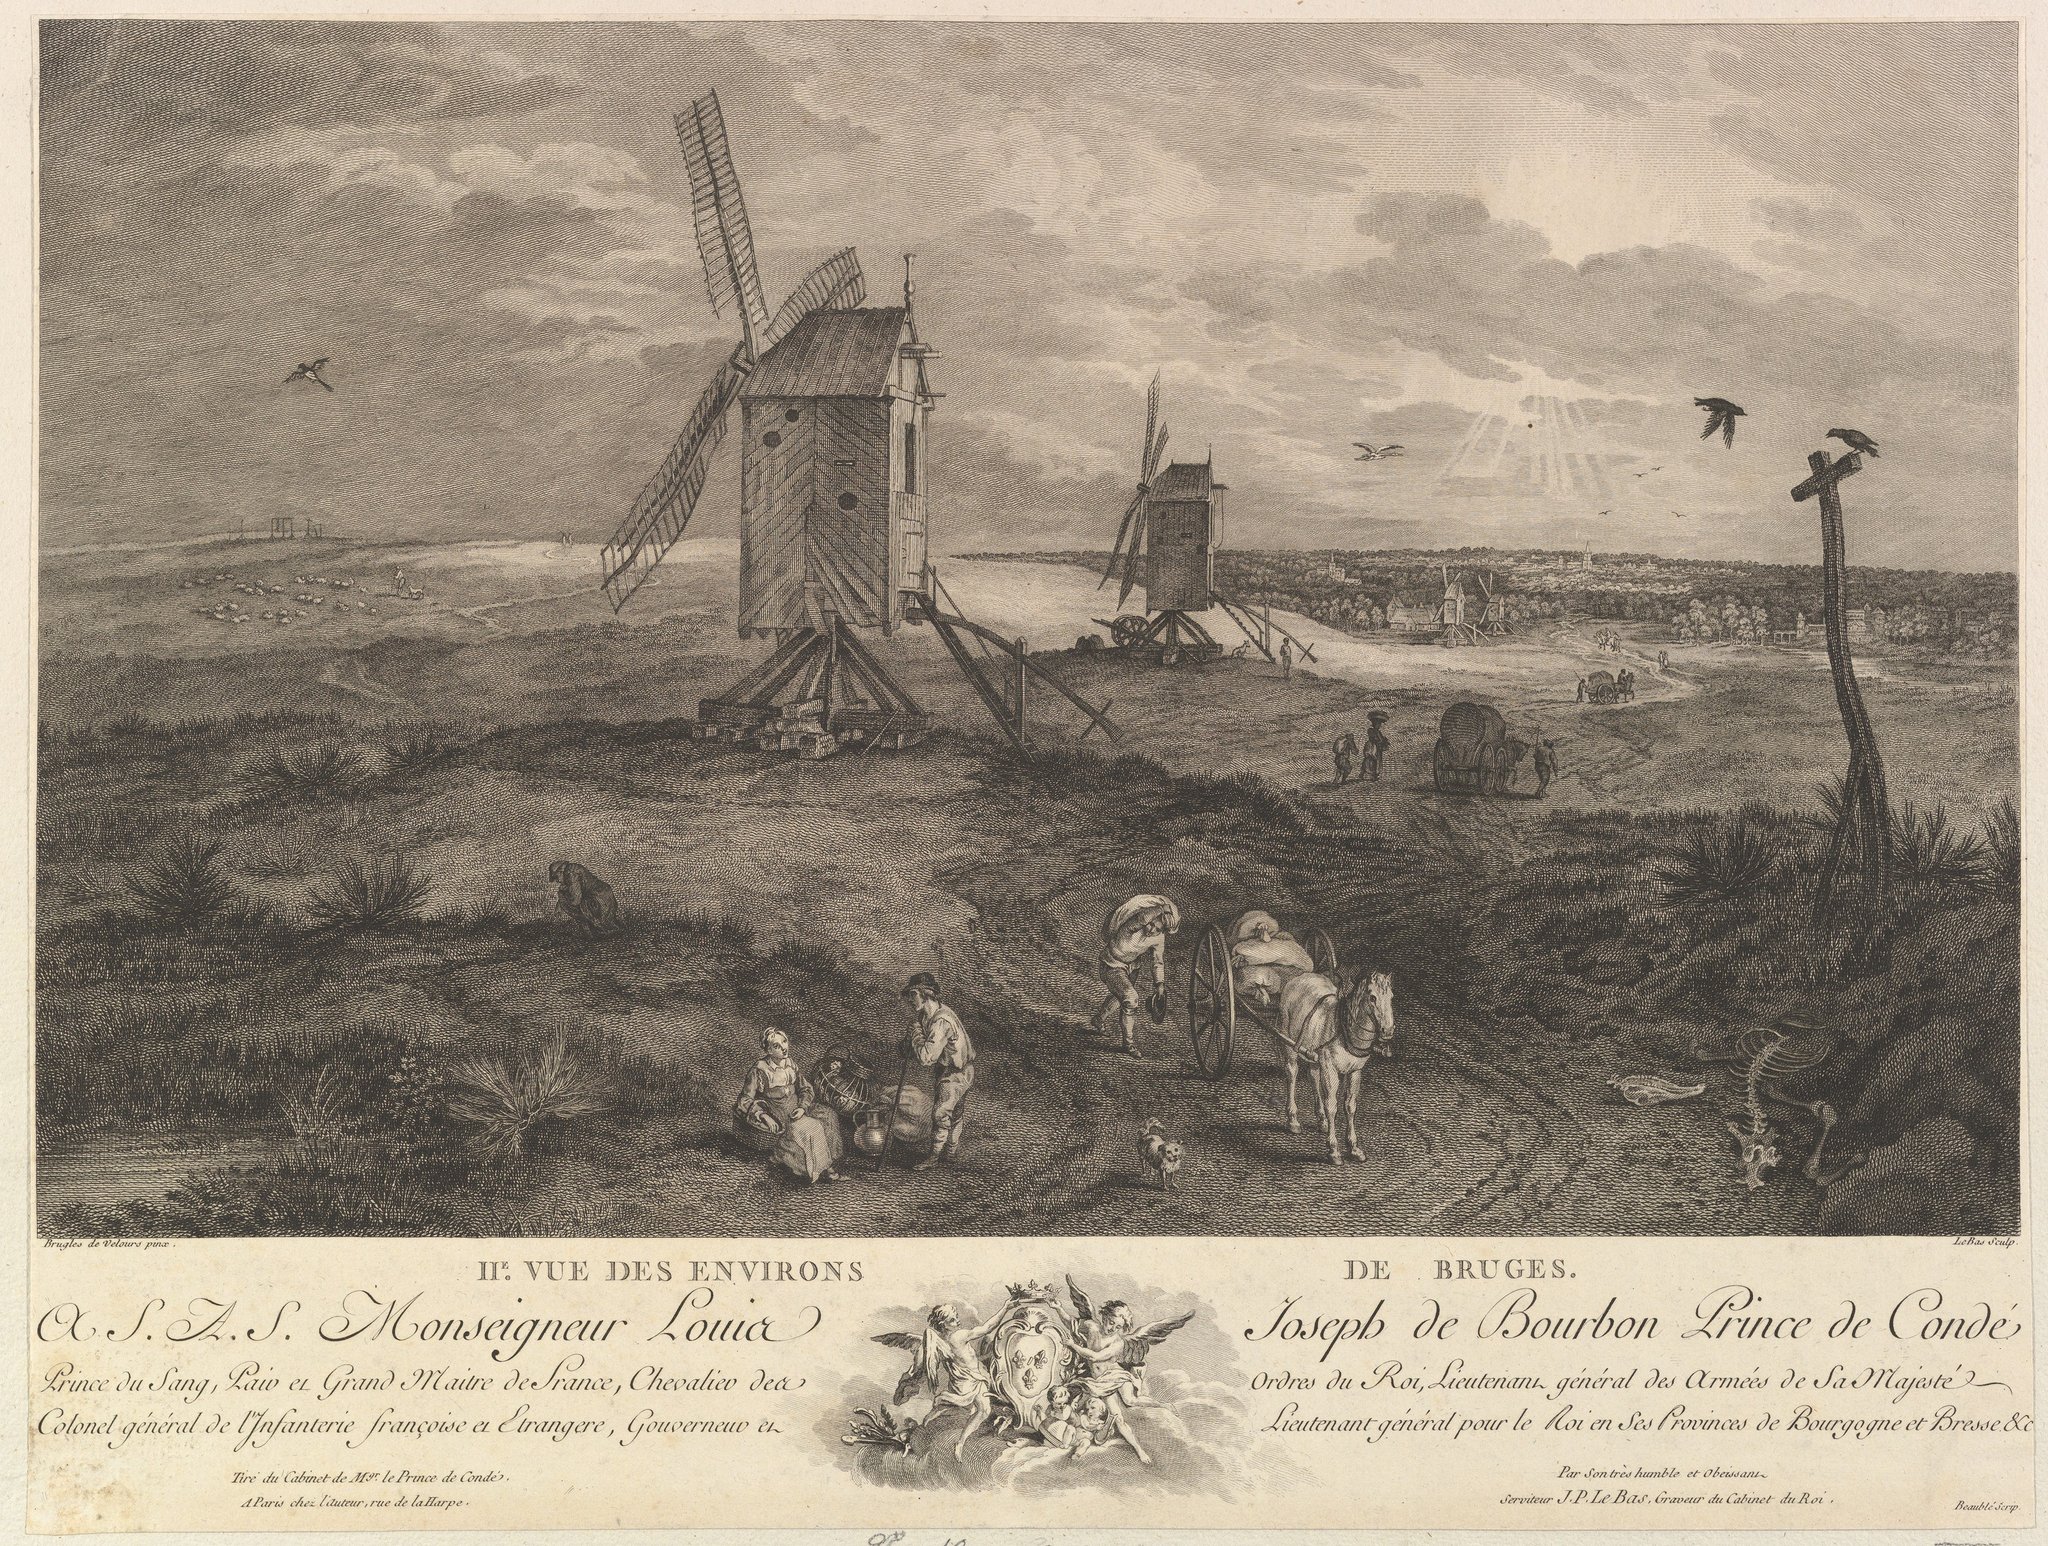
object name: print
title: Second View of the Surroundings of Bruges (IIe. Vue des environs de Bruges)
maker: jacques philippe le bas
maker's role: artist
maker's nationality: french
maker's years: 1707-1783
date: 1700-1780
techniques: engraving, etching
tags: windmills,landscapes,coat of arms,carriages